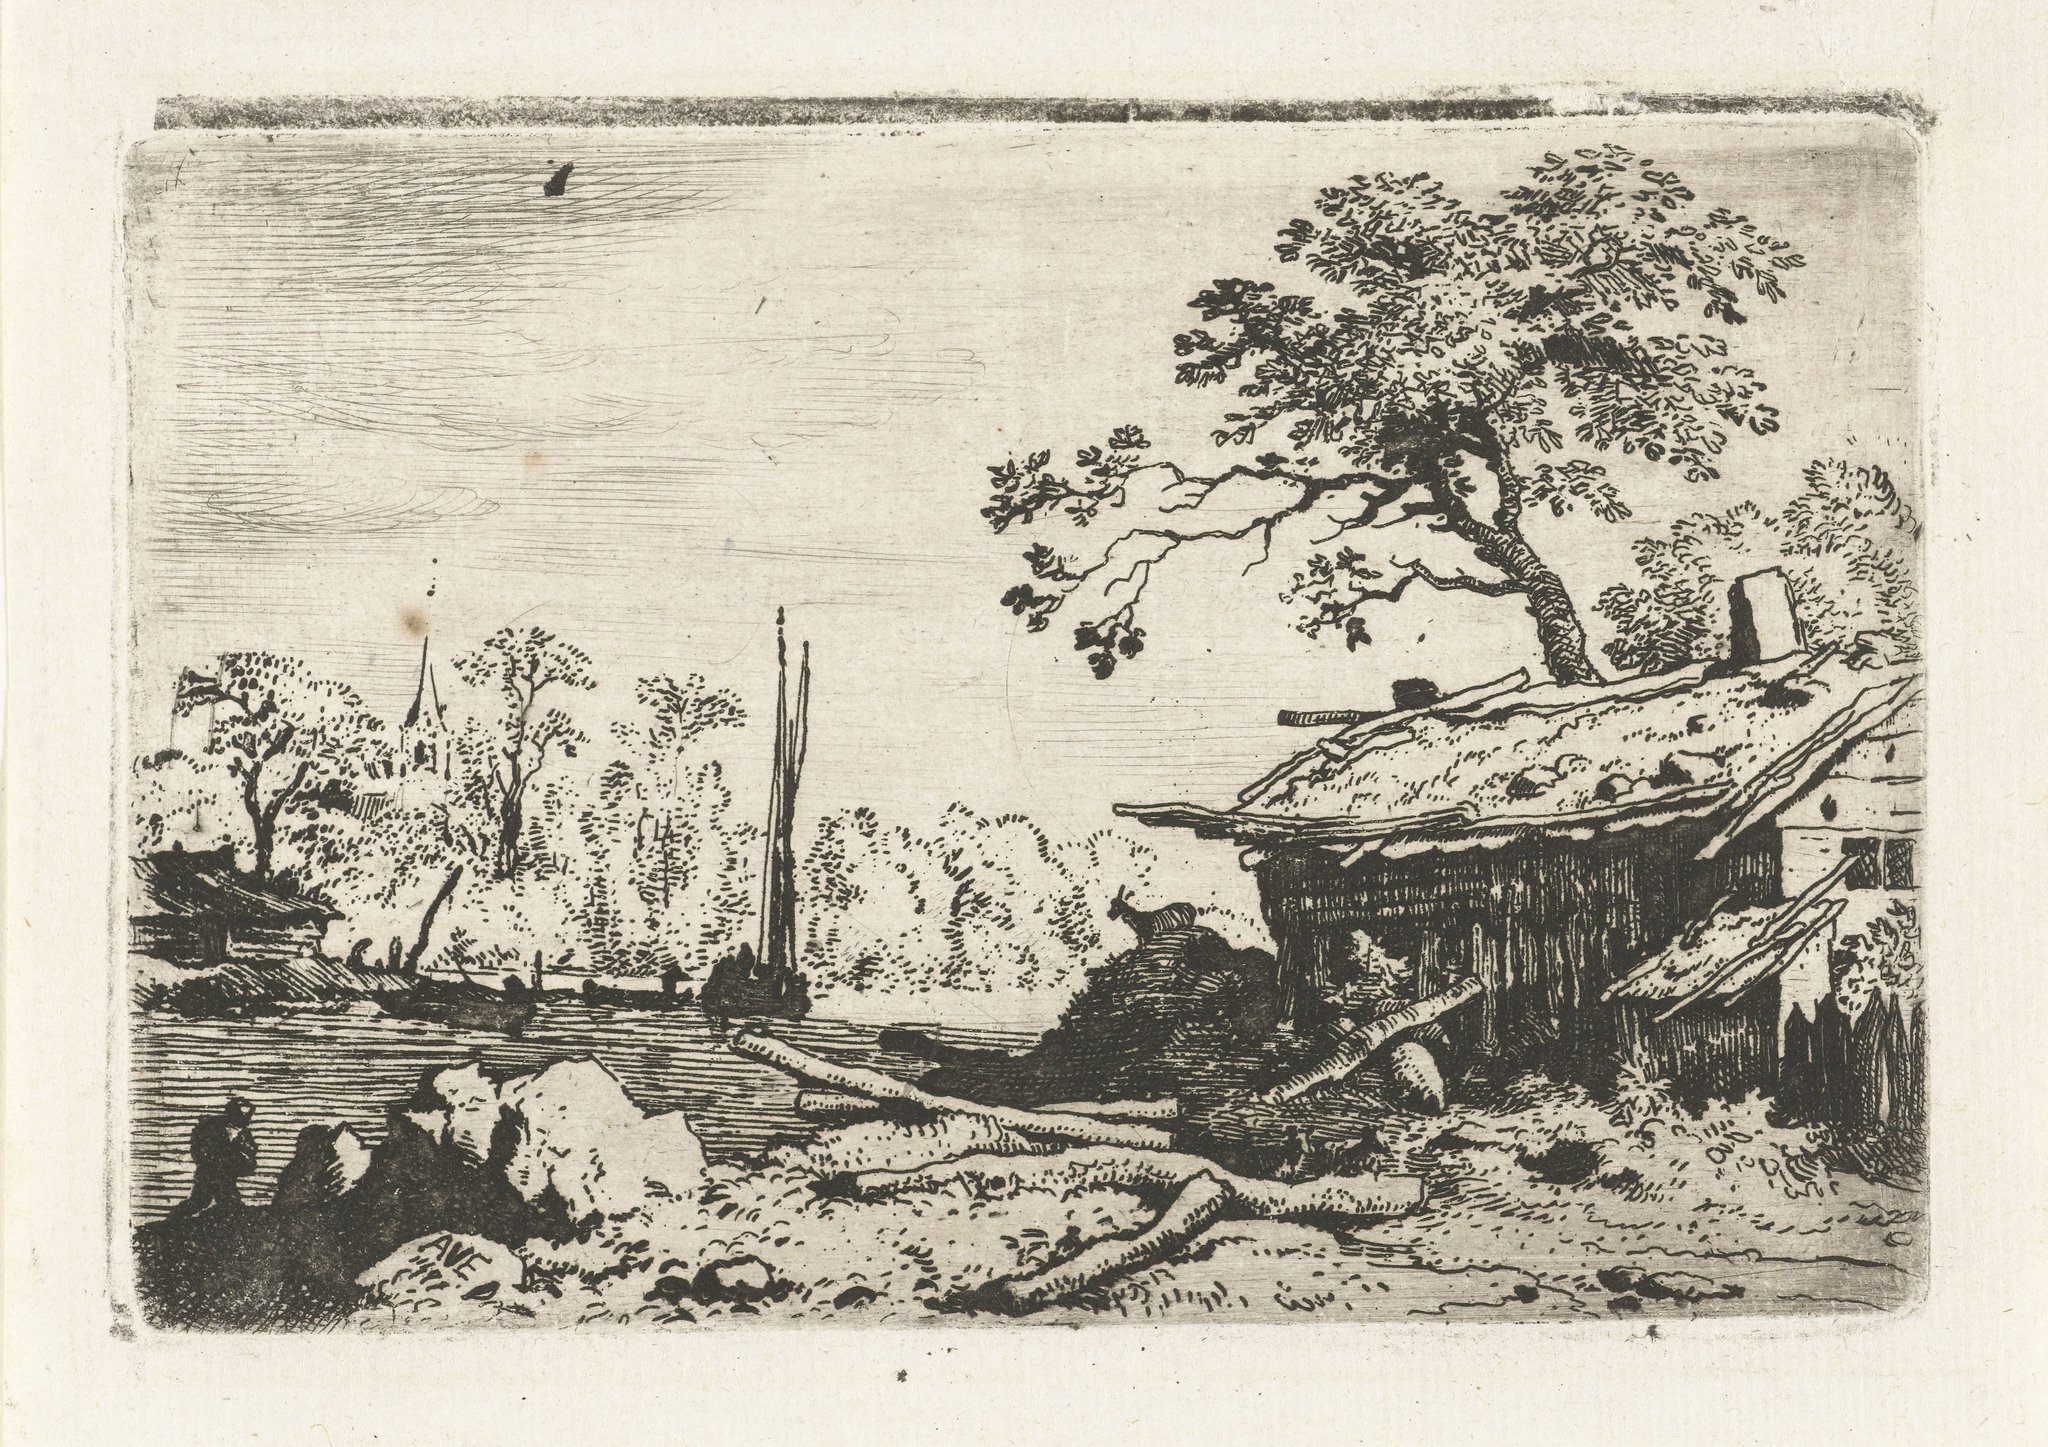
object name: print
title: Landschap met vervallen hut aan het water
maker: allaert van everdingen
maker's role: draughtsman, painter, print maker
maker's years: 1621-1675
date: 1651-1675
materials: paper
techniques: etching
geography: netherlands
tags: landscape with ruins (+ city(-scape) with figures, staffage)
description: Gezicht op een vervallen hut onder een boom, aan het water. Op de voorgrond bij twee rotsen loopt een man. Op het water enkele boten en op de achtergrond een kerktoren tussen de bomen.